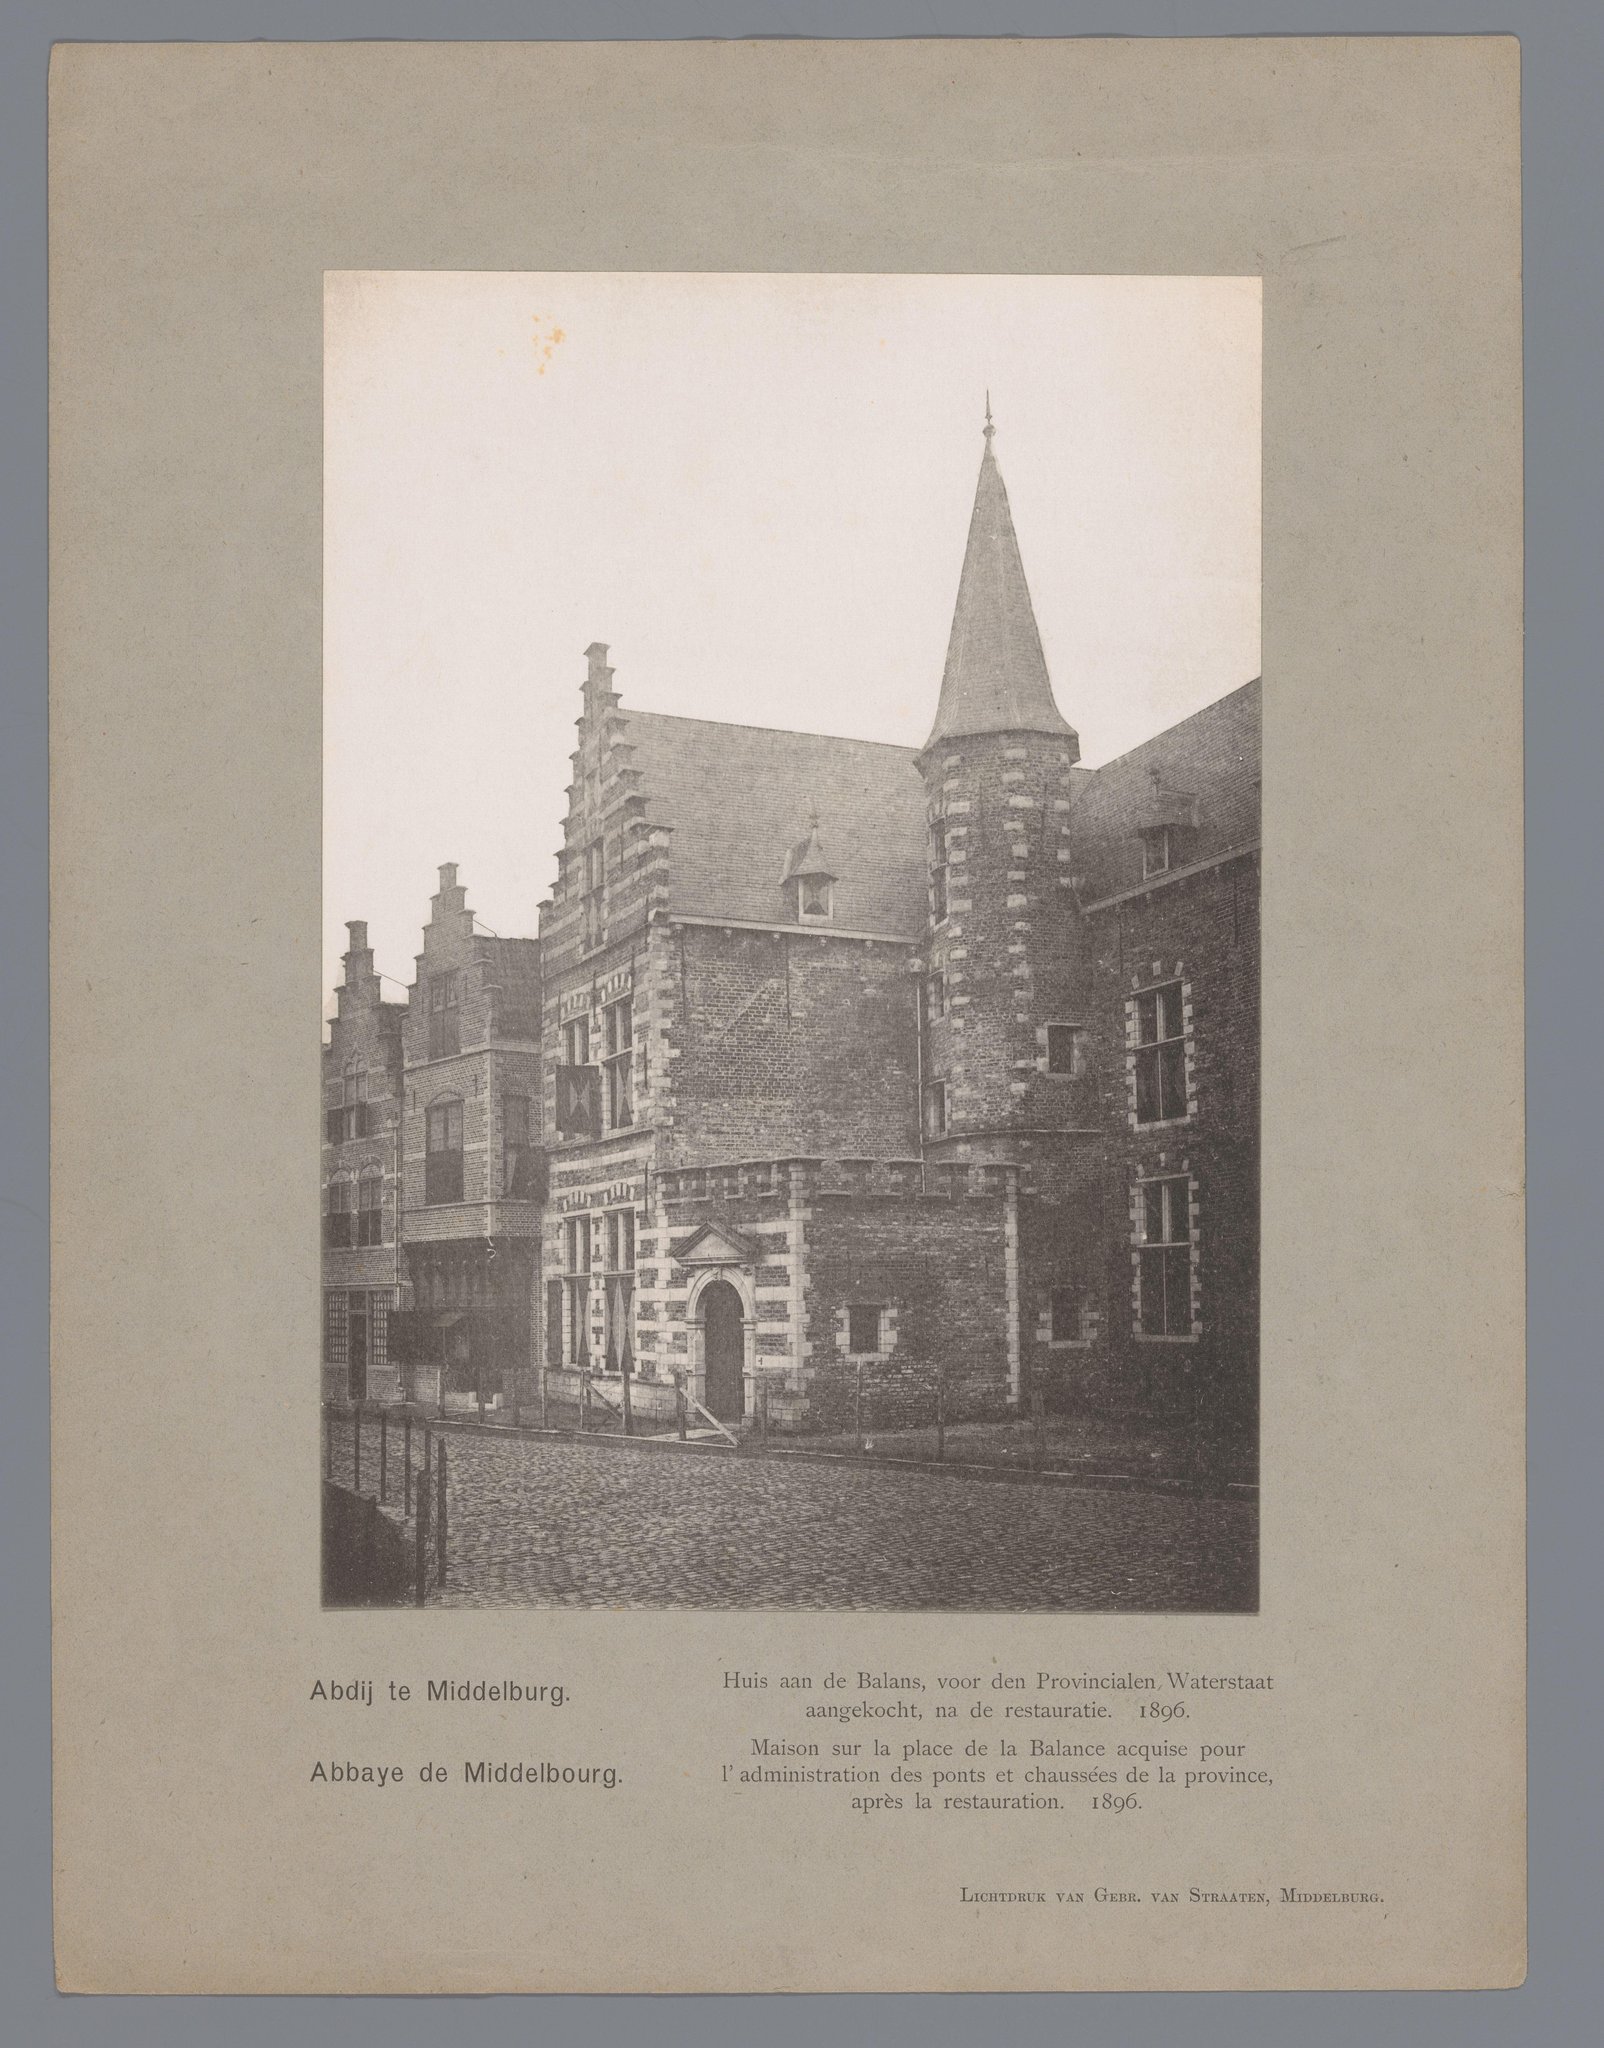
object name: photomechanical print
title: Gezicht op het Huis aan de Balans bij de Abdij van Middelburg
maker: Anonymous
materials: paper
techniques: photograph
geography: middelburg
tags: abbey, monastery, convent ~ roman catholic church